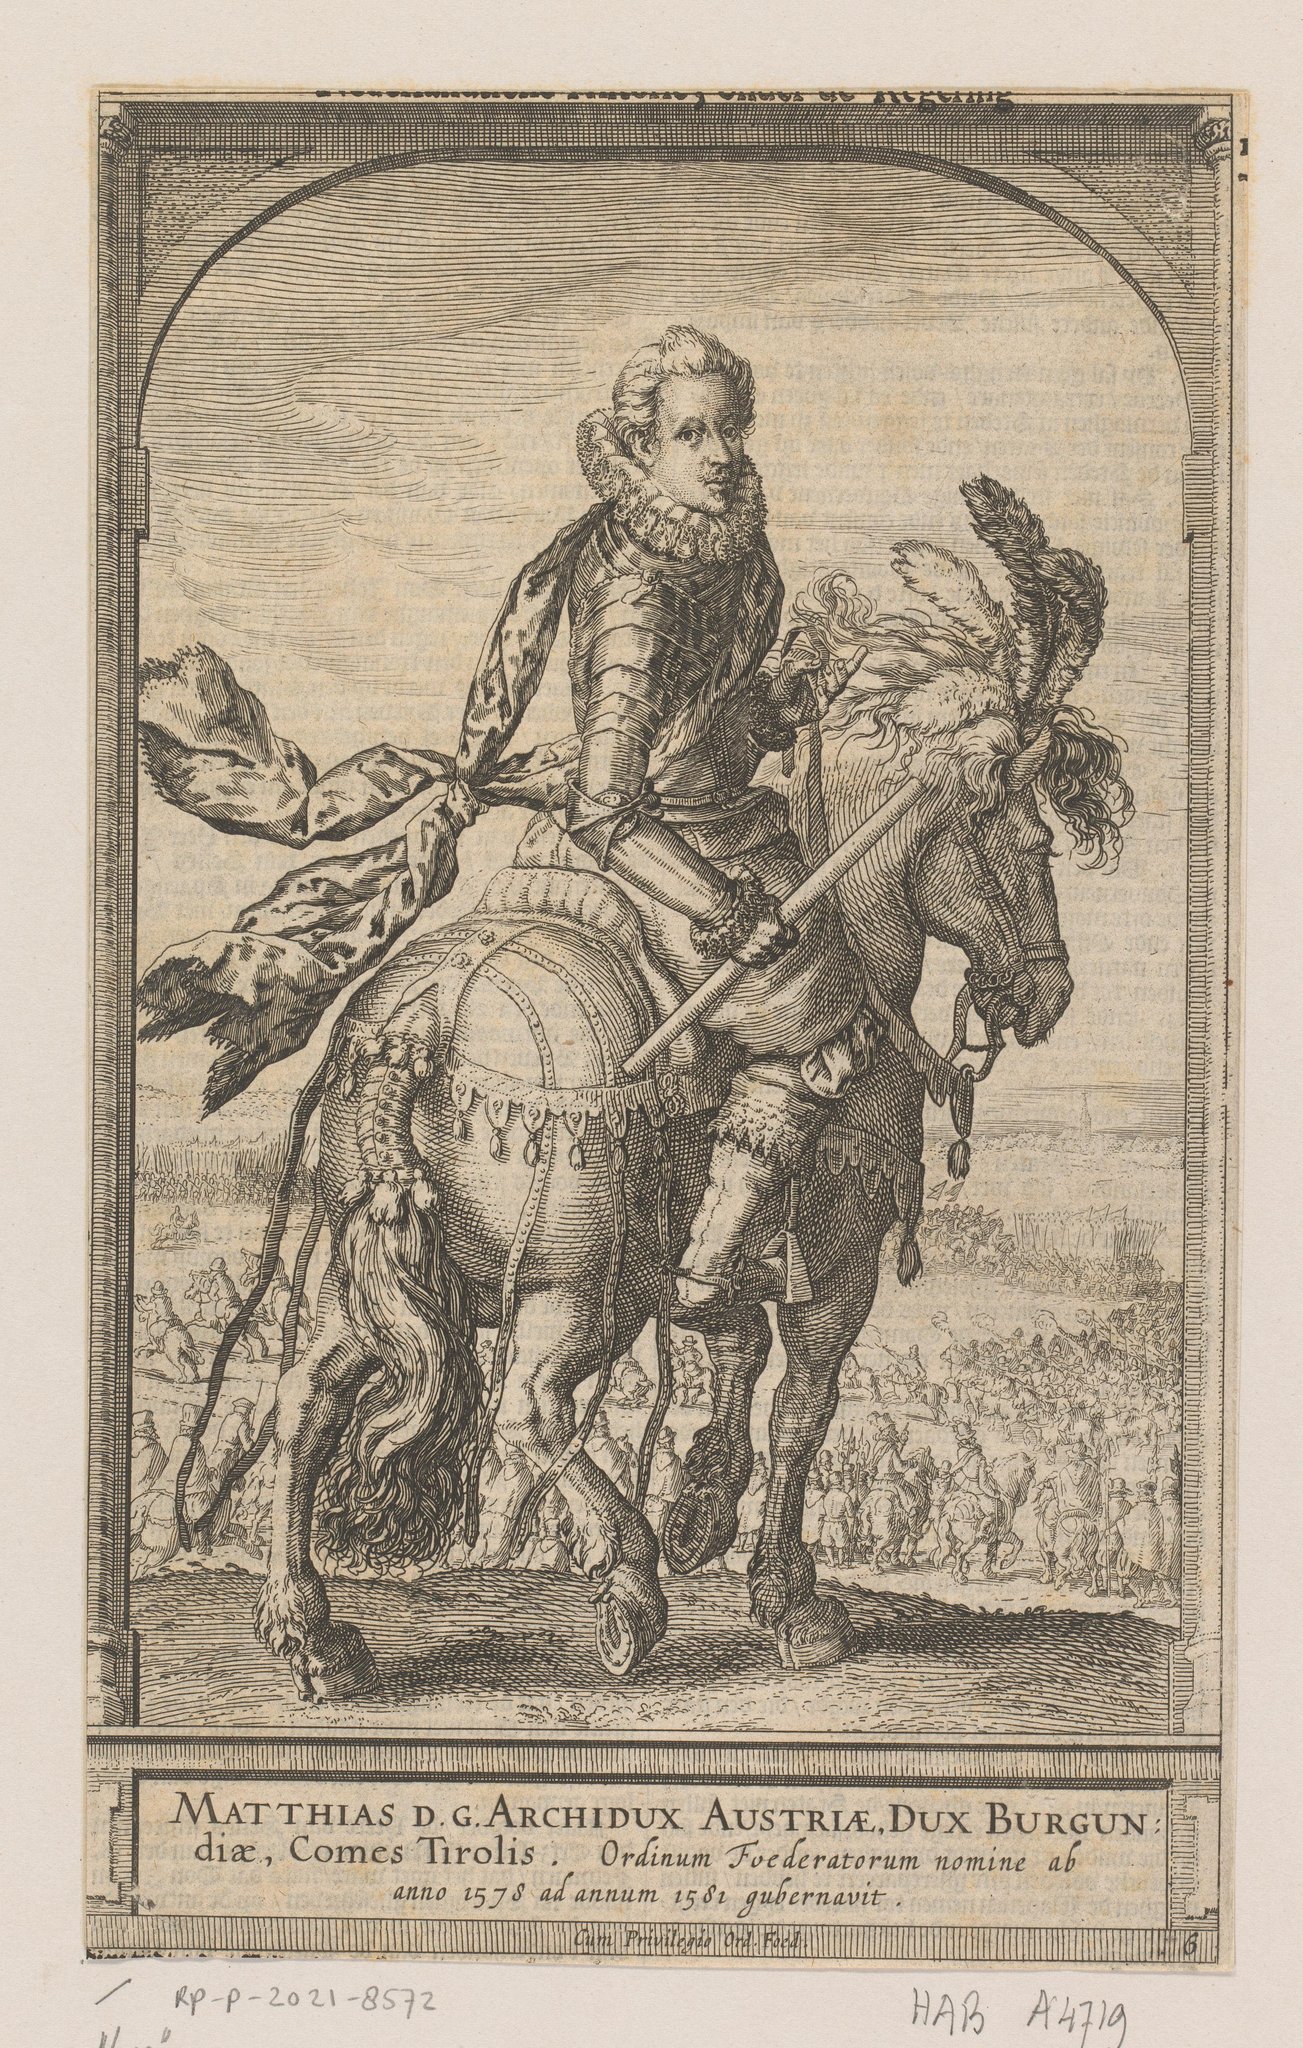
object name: book illustration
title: Landvoogden van de Nederlanden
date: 1652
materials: paper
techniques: etching, letterpress printing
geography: amsterdam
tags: vienna, matthias van oostenrijk (rooms-duits keizer), equestrian state-portrait, historical persons, emperor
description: Prent uit: Meteren, Emanuel van. Historien der Nederlanden, en haar naburen oorlogen tot het Iaar 1612. Amsterdam: Jan Jacobsz. Schipper, 1652.